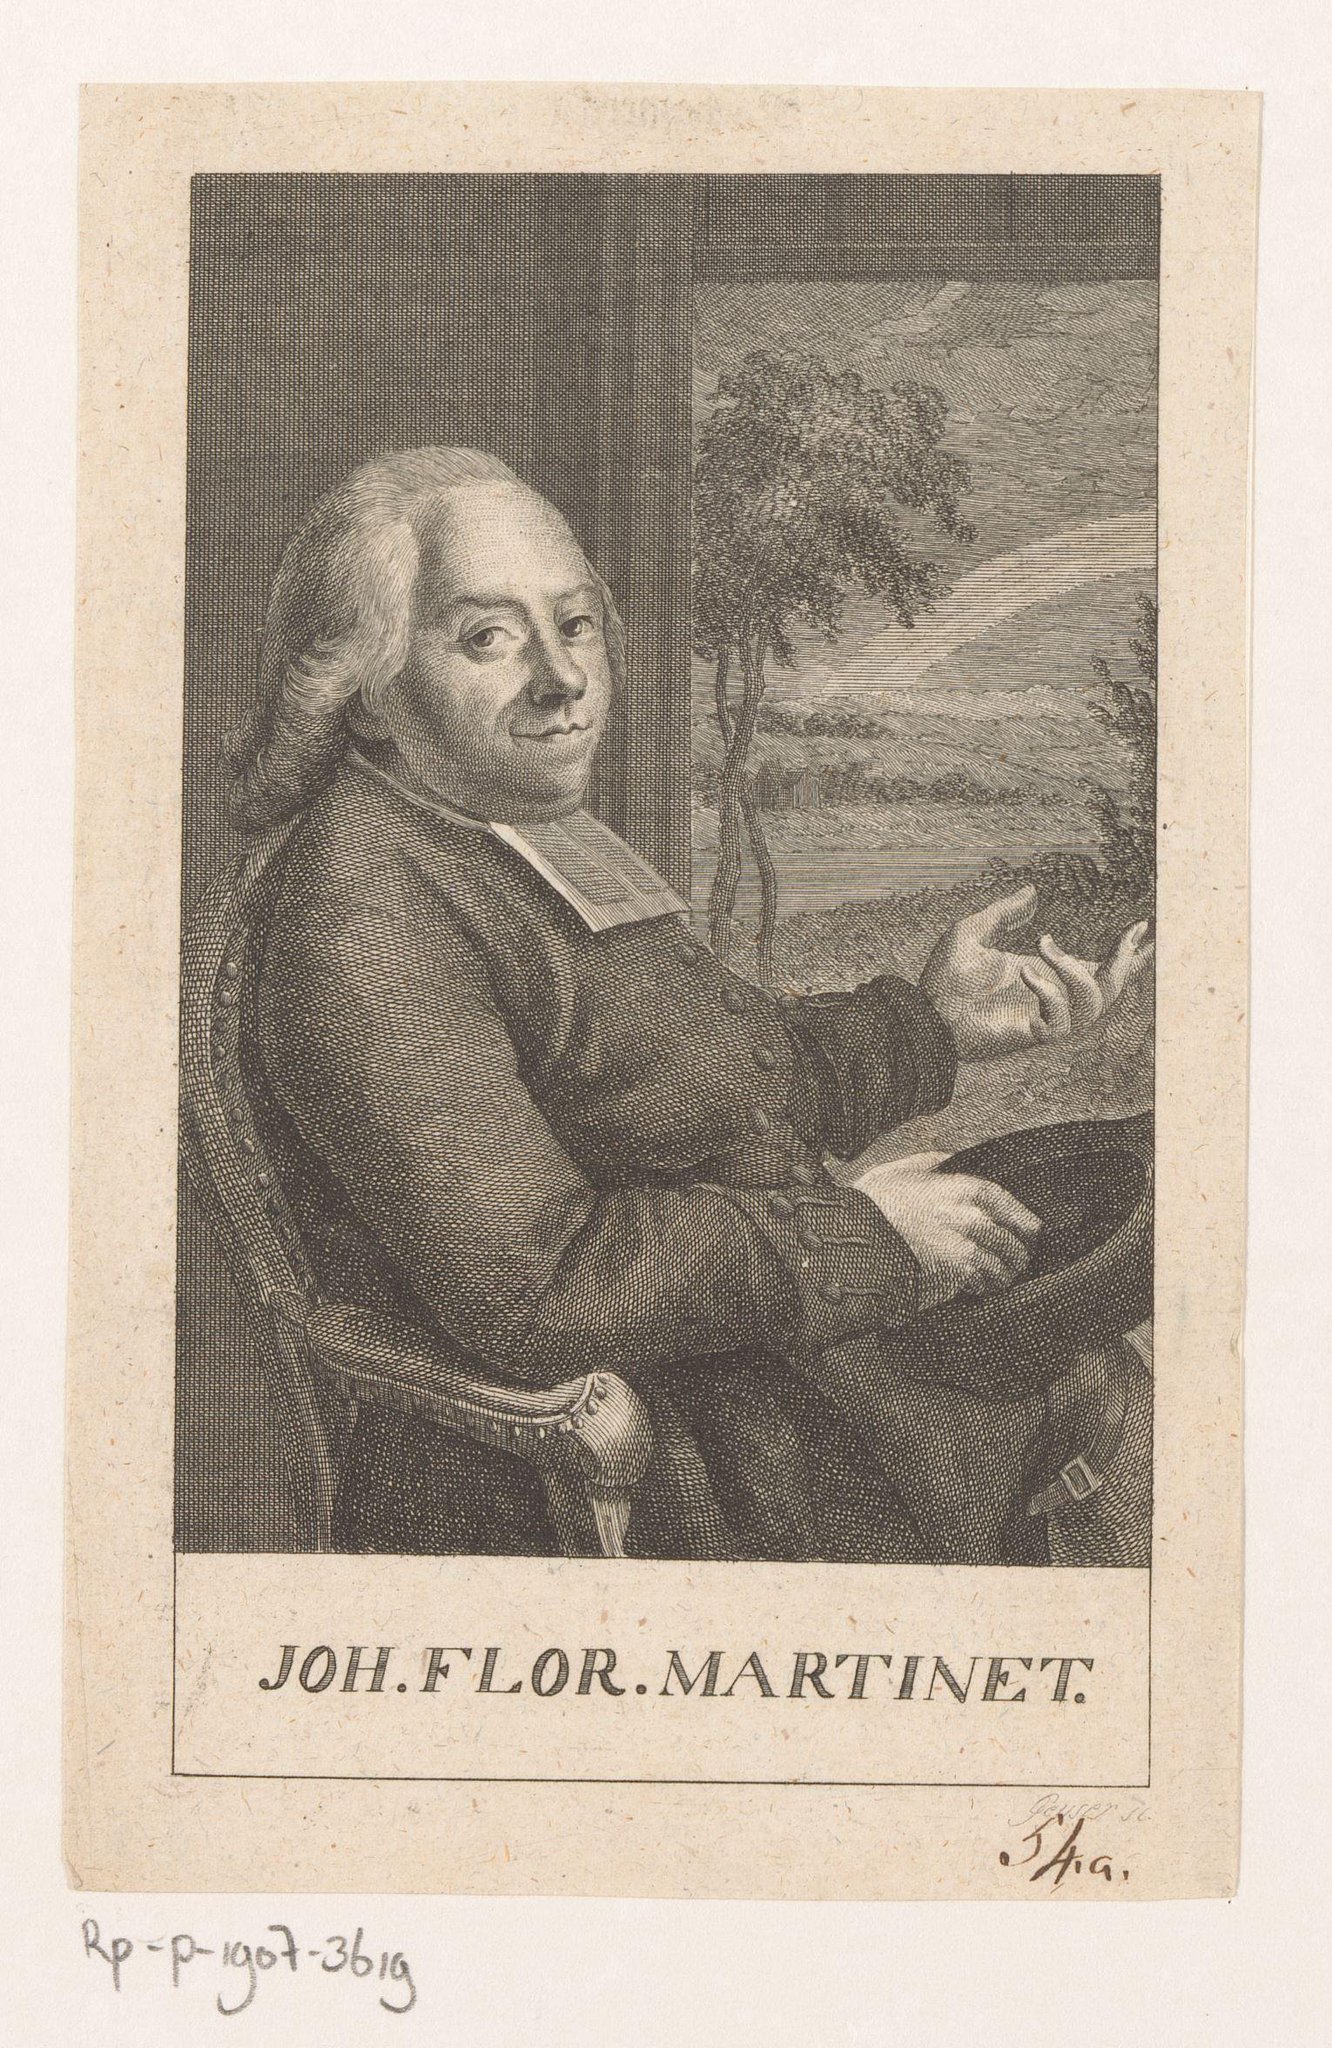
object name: print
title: Portret van Johannes Florentius Martinet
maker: christian gottlieb geyser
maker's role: print maker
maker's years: 1742-1803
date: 1752-1795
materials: paper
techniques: engraving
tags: amsterdam, joannes florentius martinet, theologian, historical persons, rainbow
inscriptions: collector's mark: Lugt 2228